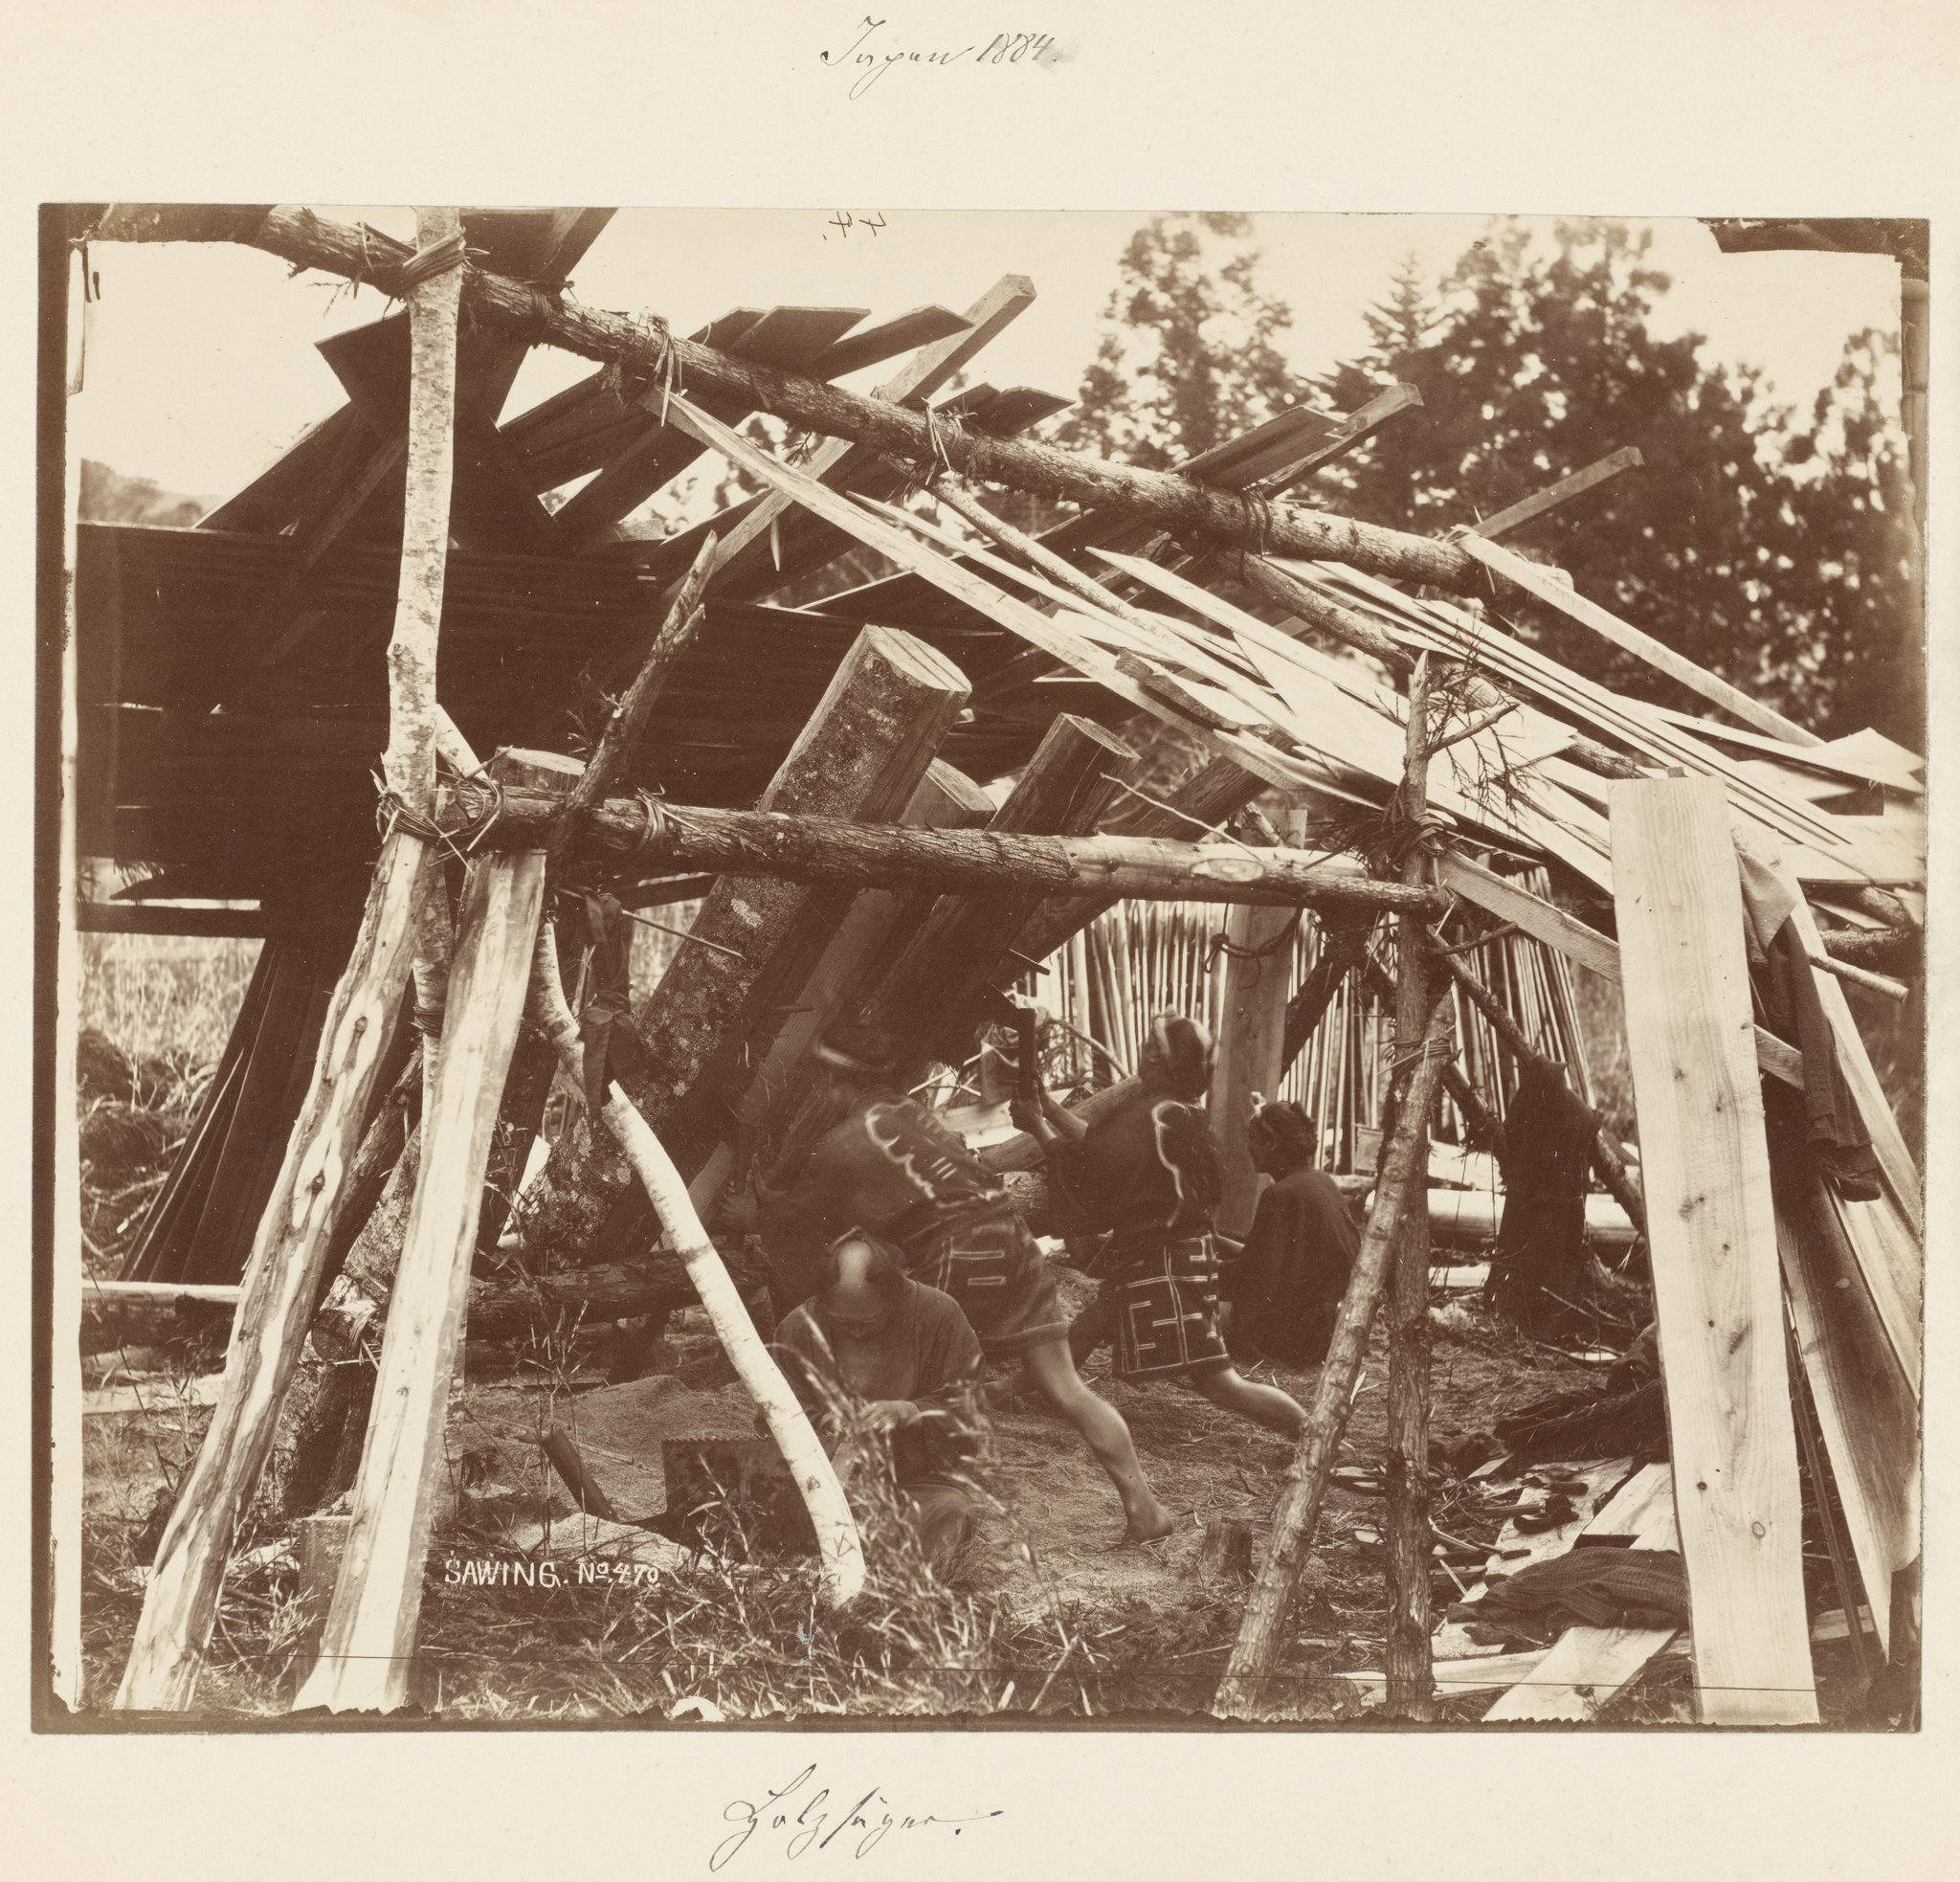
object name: photograph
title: Vier mensen bouwen een houten woning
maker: Anonymous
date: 1884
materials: cardboard, paper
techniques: albumen print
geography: japan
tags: building activities, tools, aids, implements ~ crafts and industries: axe, tools, aids, implements ~ crafts and industries: saw, japan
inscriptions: number: ‘No 470.’